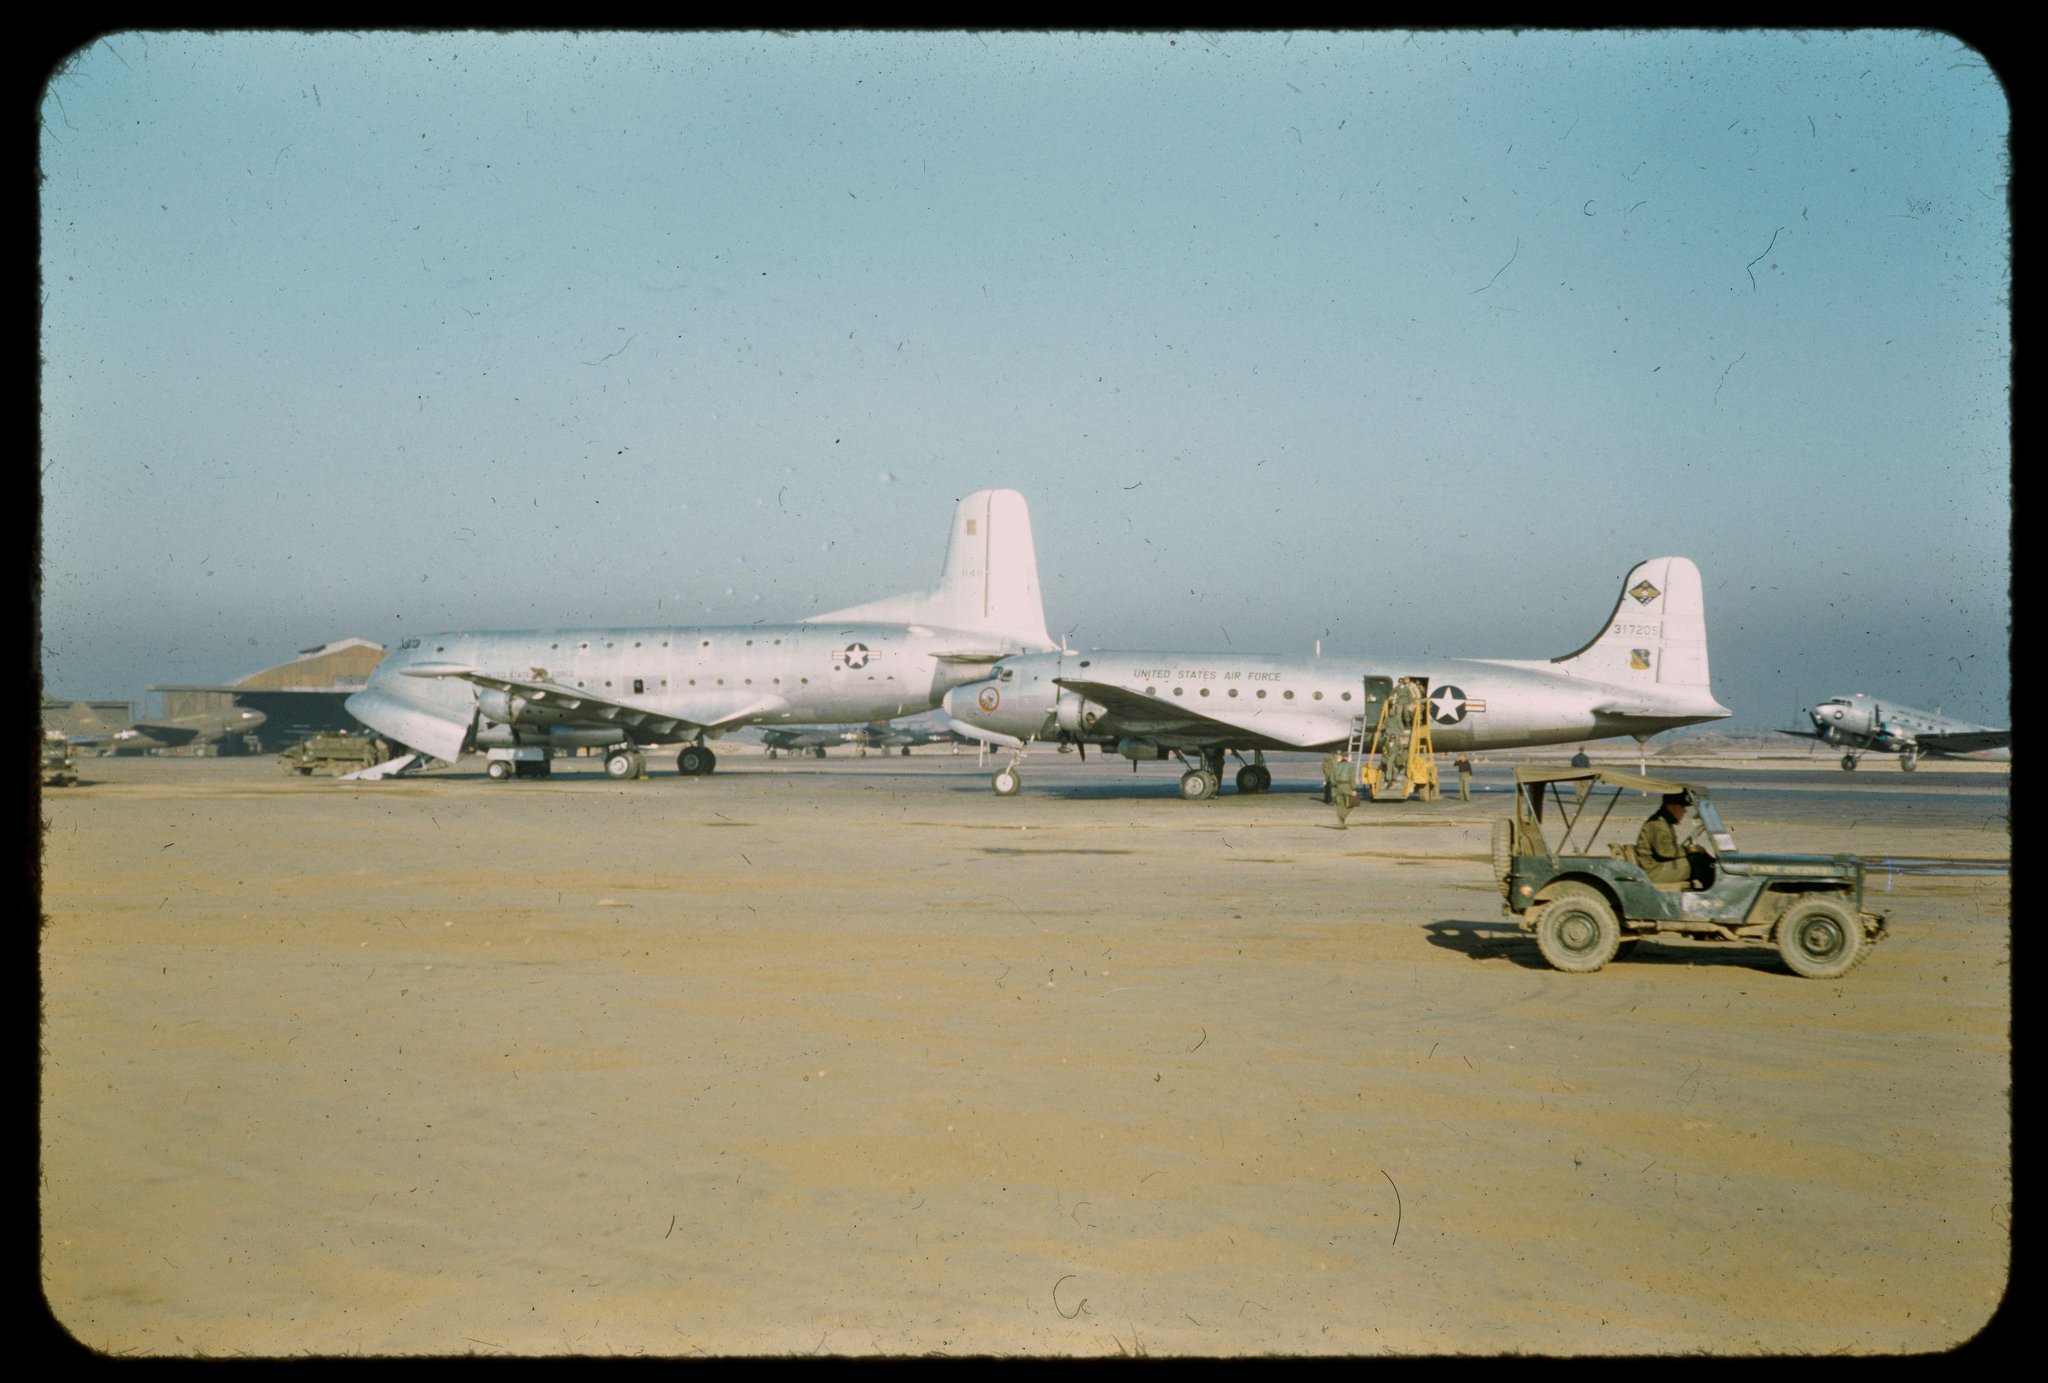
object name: color slide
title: Seoul Airport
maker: david ketel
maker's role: diplomaat, sinoloog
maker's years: 1913-2008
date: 1951-1953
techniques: slide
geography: seoul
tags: united nations